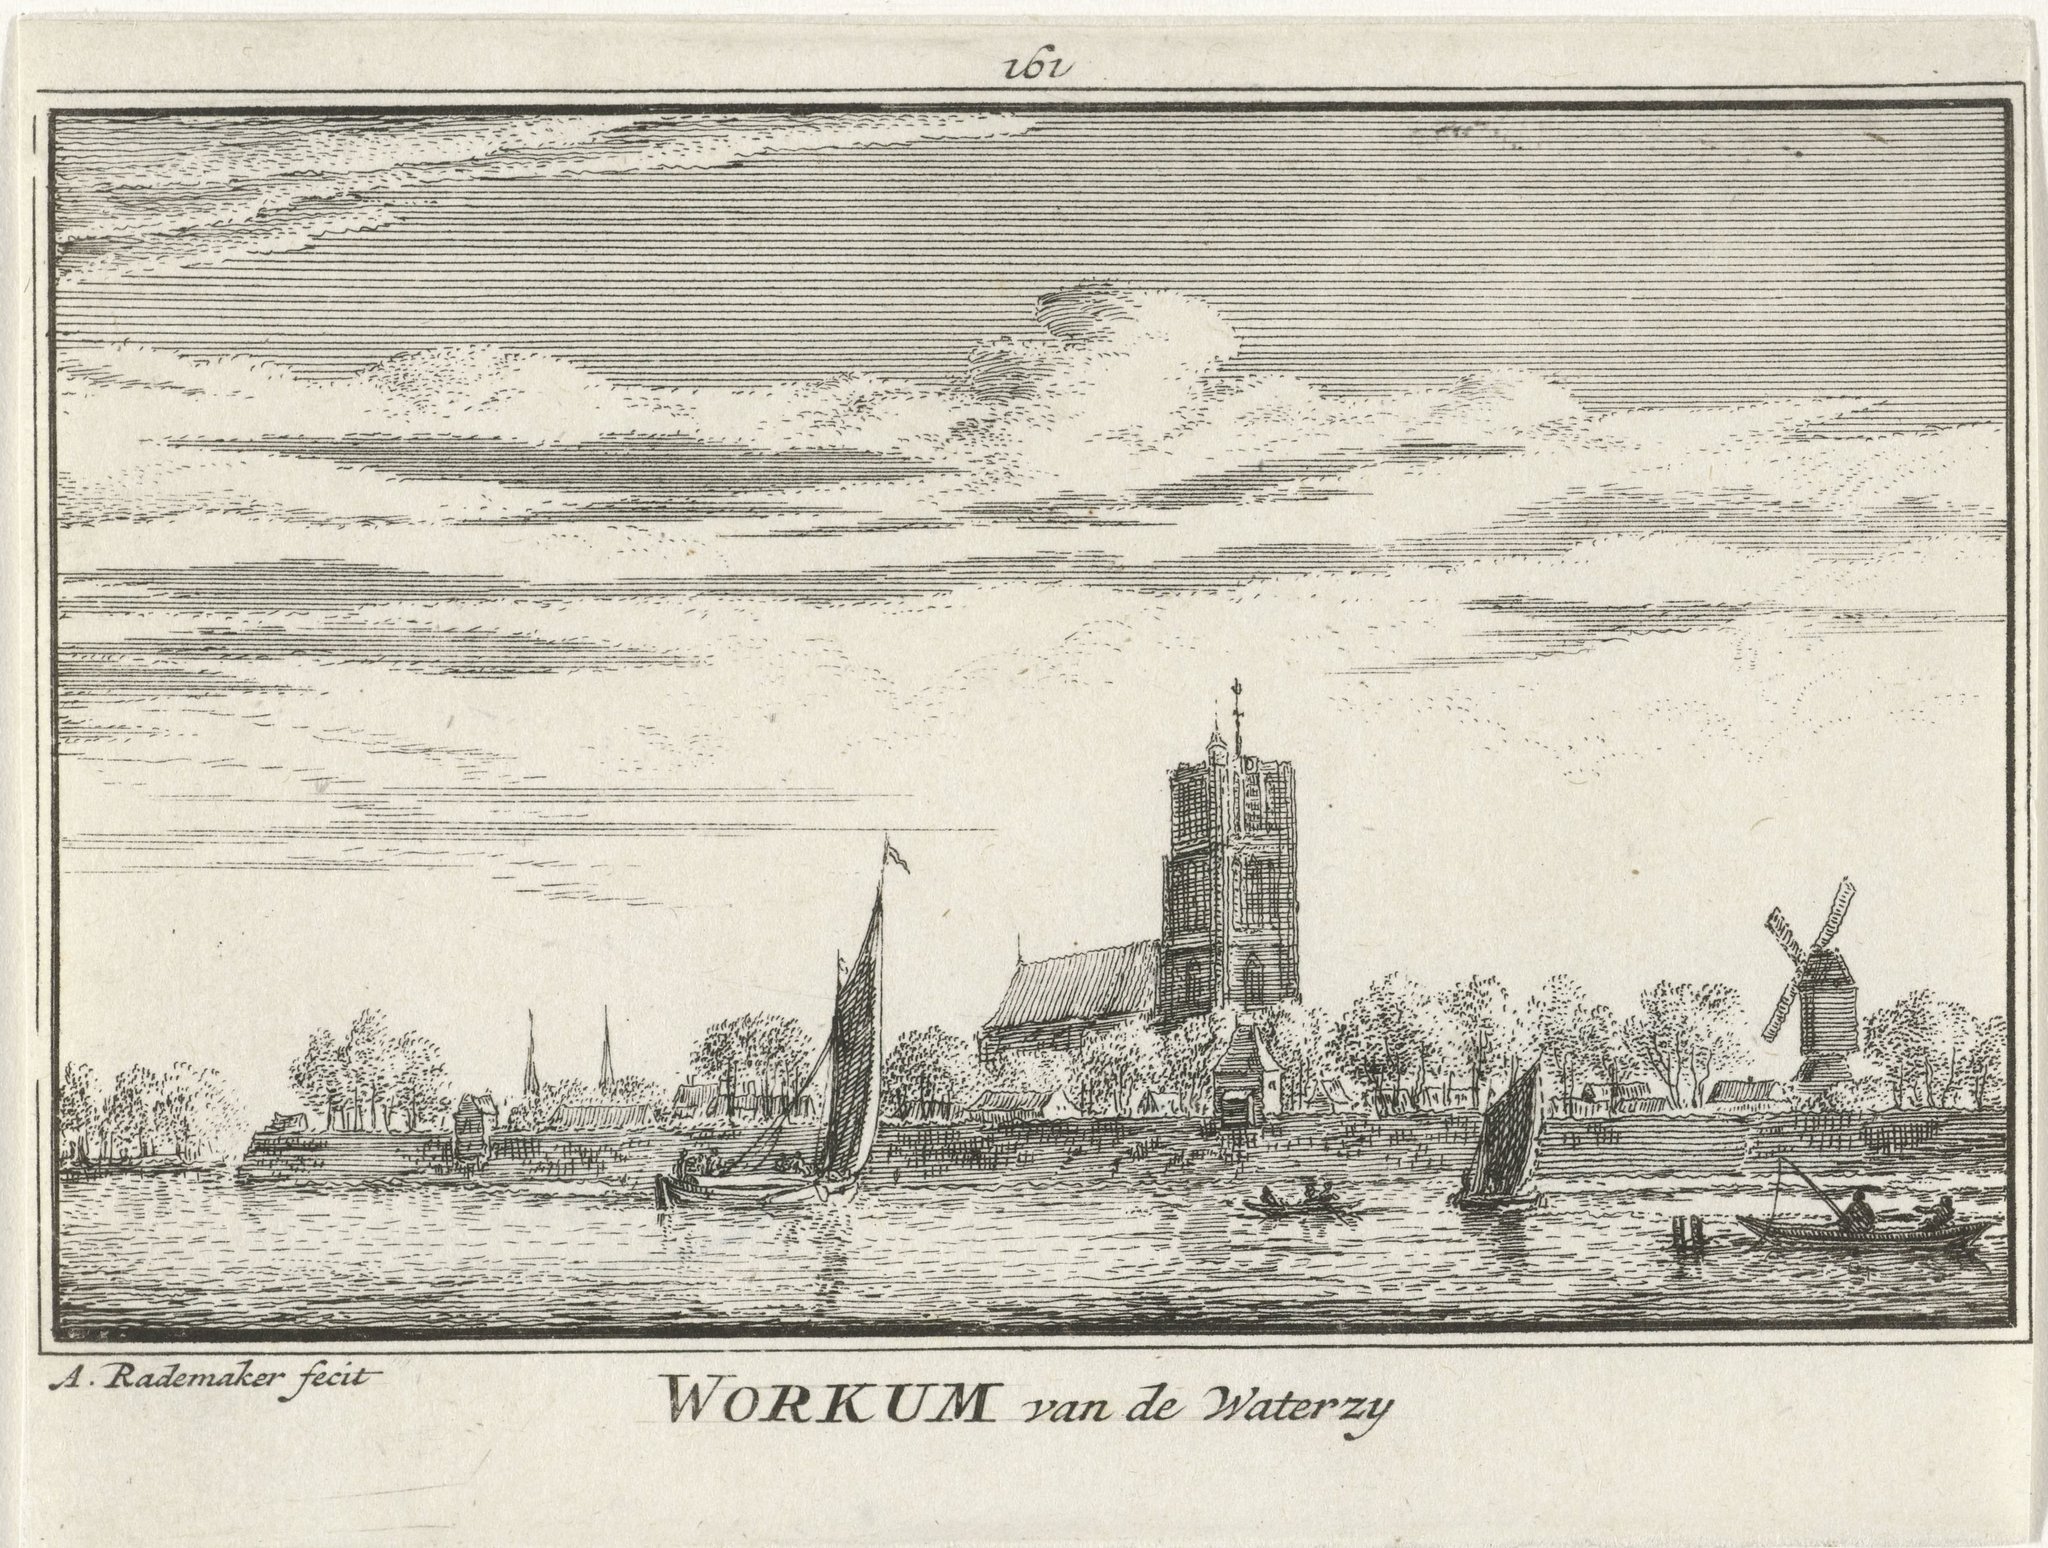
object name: book illustration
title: Workum van de waterzy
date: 1727-1733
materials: paper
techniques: etching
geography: amsterdam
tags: river, church (exterior), windmill, prospect of city, town panorama, silhouette of city, woudrichem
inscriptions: collector's mark: Lugt 2228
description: Illustratie uit: Abraham Rademaker, Matthaeus Brouërius van Niedek, Isaac Le Long, Kabinet van Nederlandsche en Kleefsche outheden en (...) voorname stads- en landgebouwen, Willem Barents en Antoni Schoonenburg: Amsterdam, 1727-1733, ill. nr. 161.